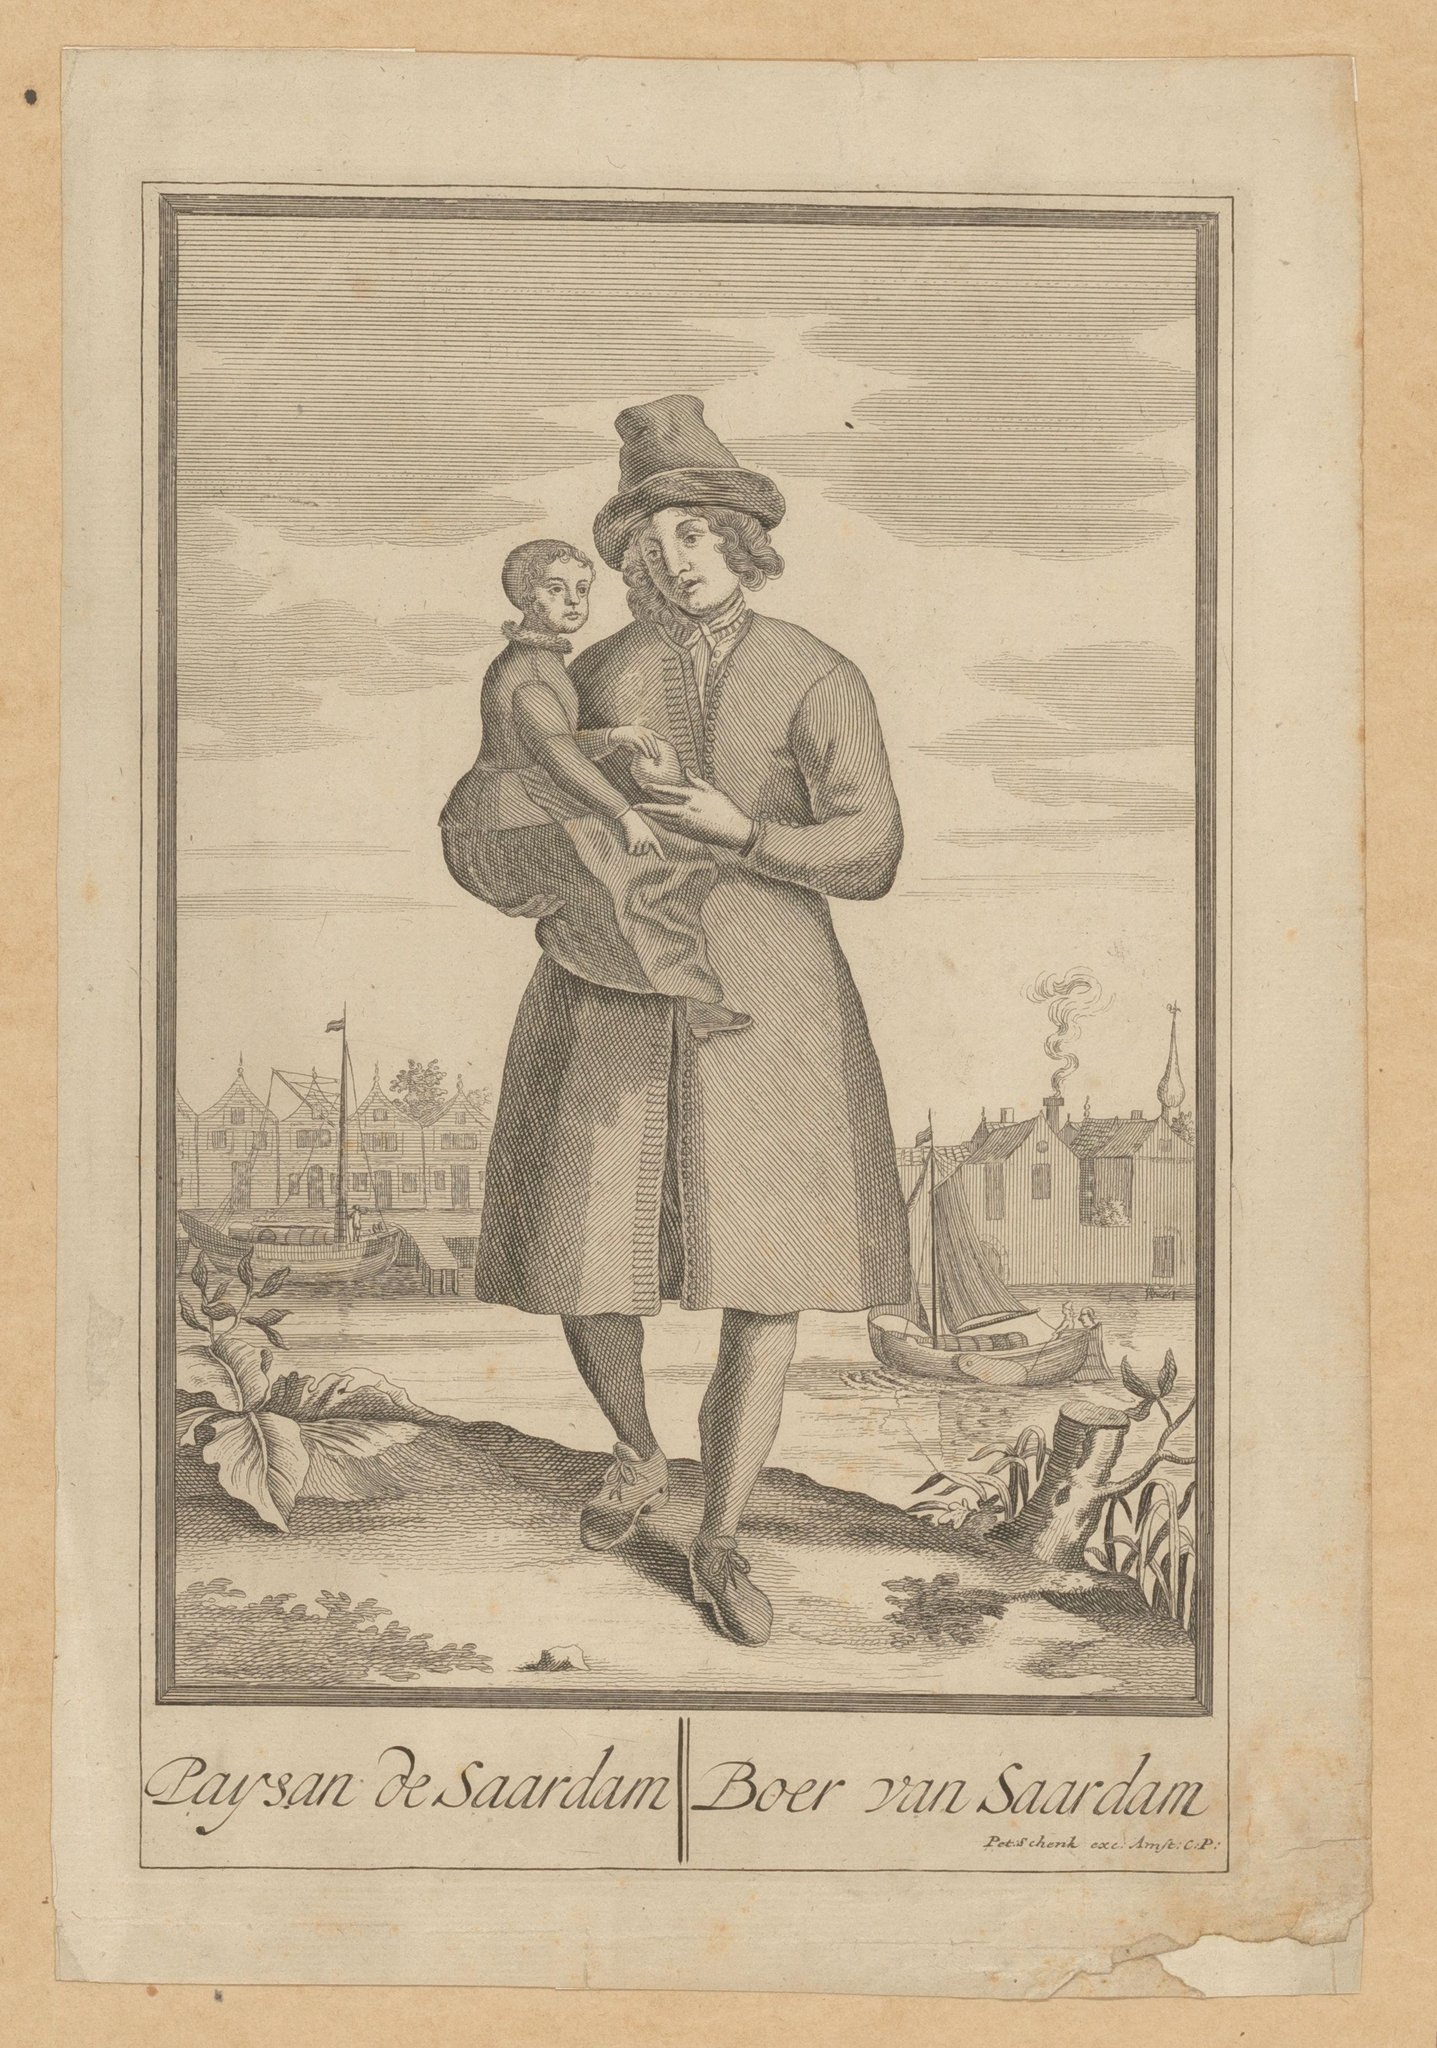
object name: print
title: Paysan de Saardam / Boer van Saardam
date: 1689-1713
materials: paper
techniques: engraving, etching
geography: netherlands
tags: clothes, costume (+ children's clothes), farmers, clothes, costume (+ men's clothes), folk costume, regional costume, father and child(ren), man and child(ren) (family group)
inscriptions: collector's mark: Lugt 1641, collector's mark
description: Een boer uit Zaandam, staande met een kind op de arm. Ongenummerd. Prent uit een serie prenten naar Pieter van den Berge met dorpelingen die klederdrachten dragen. Onderwerpsrubrieken binnen de Atlas Zeden en Gewoonten: De Kleeding, Volkskleederdracht, Noord-Holland.